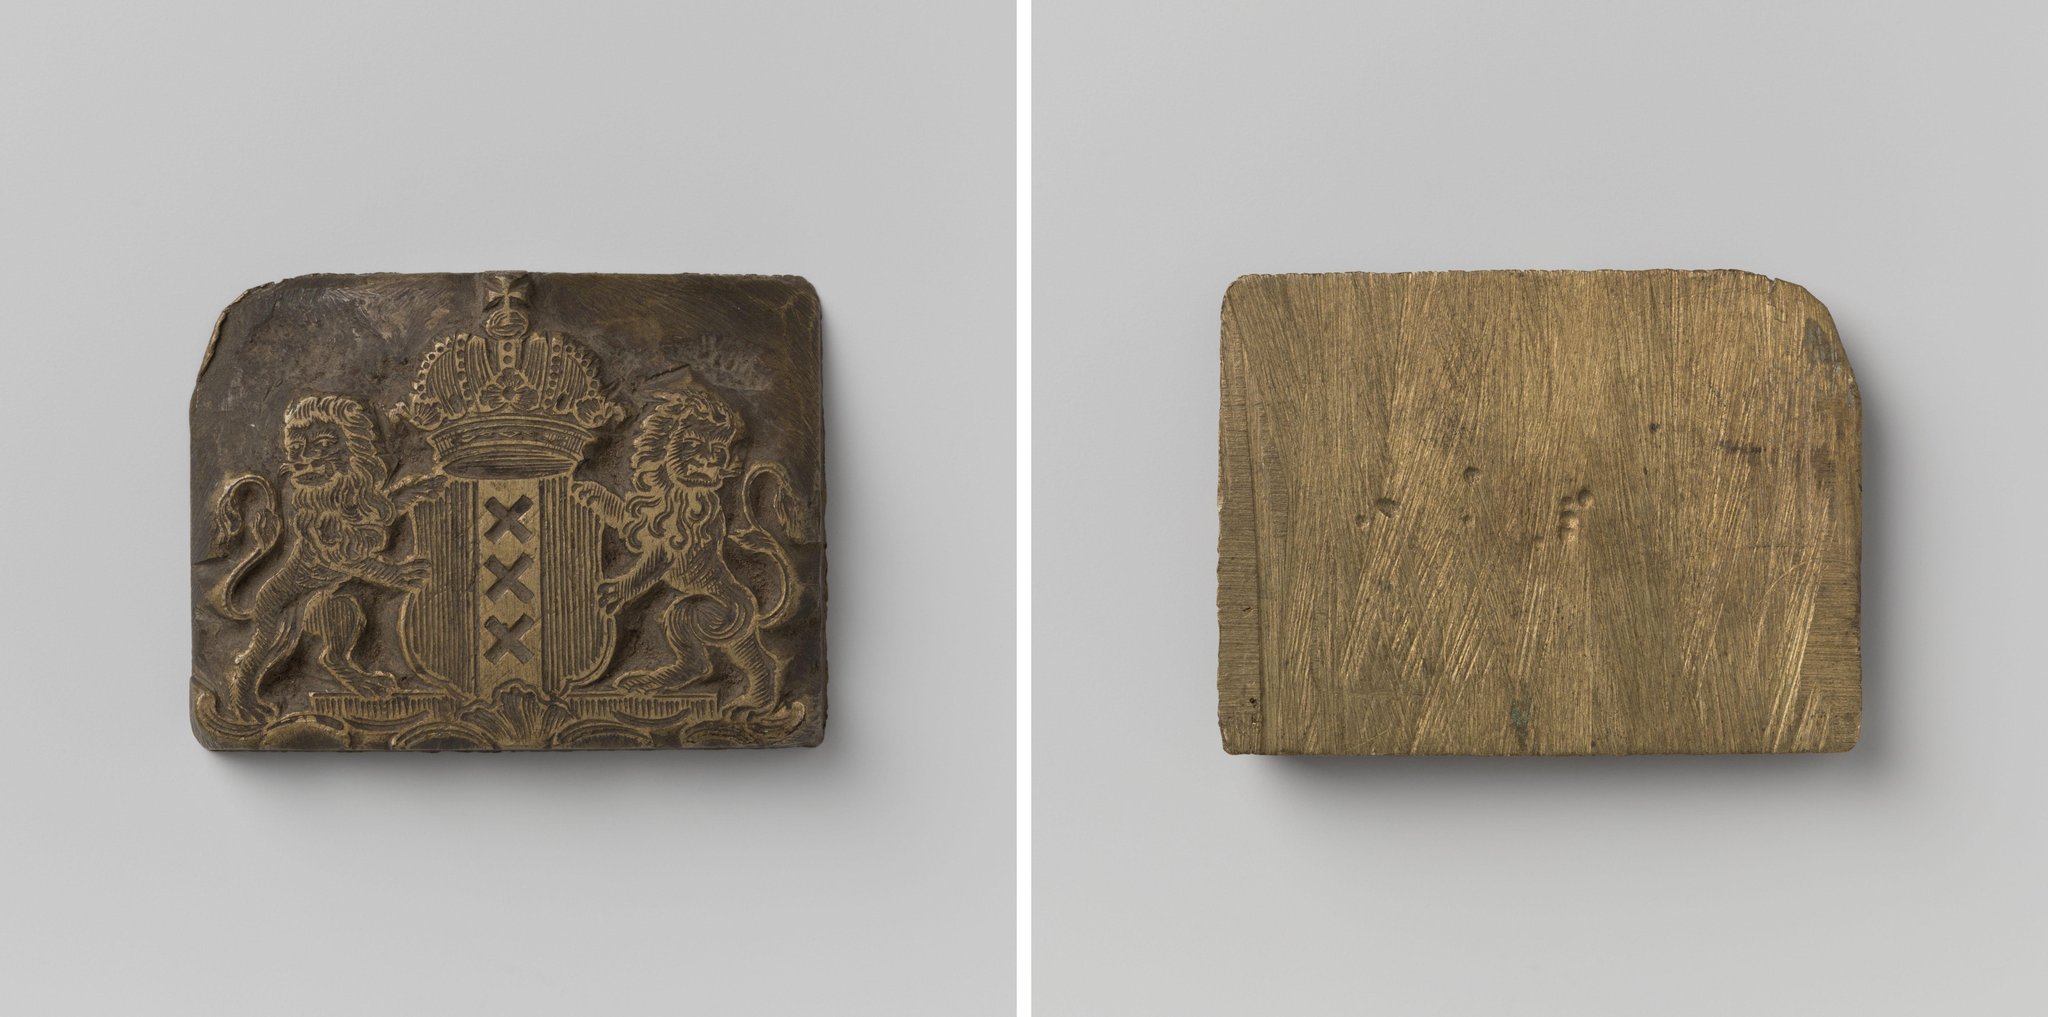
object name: stamp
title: Wapenschild van Amsterdam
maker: Anonymous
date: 1750-1850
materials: copper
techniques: cutting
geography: amsterdam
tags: amsterdam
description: gekroond wapenschild, geflankeerd door twee staande leeuwen